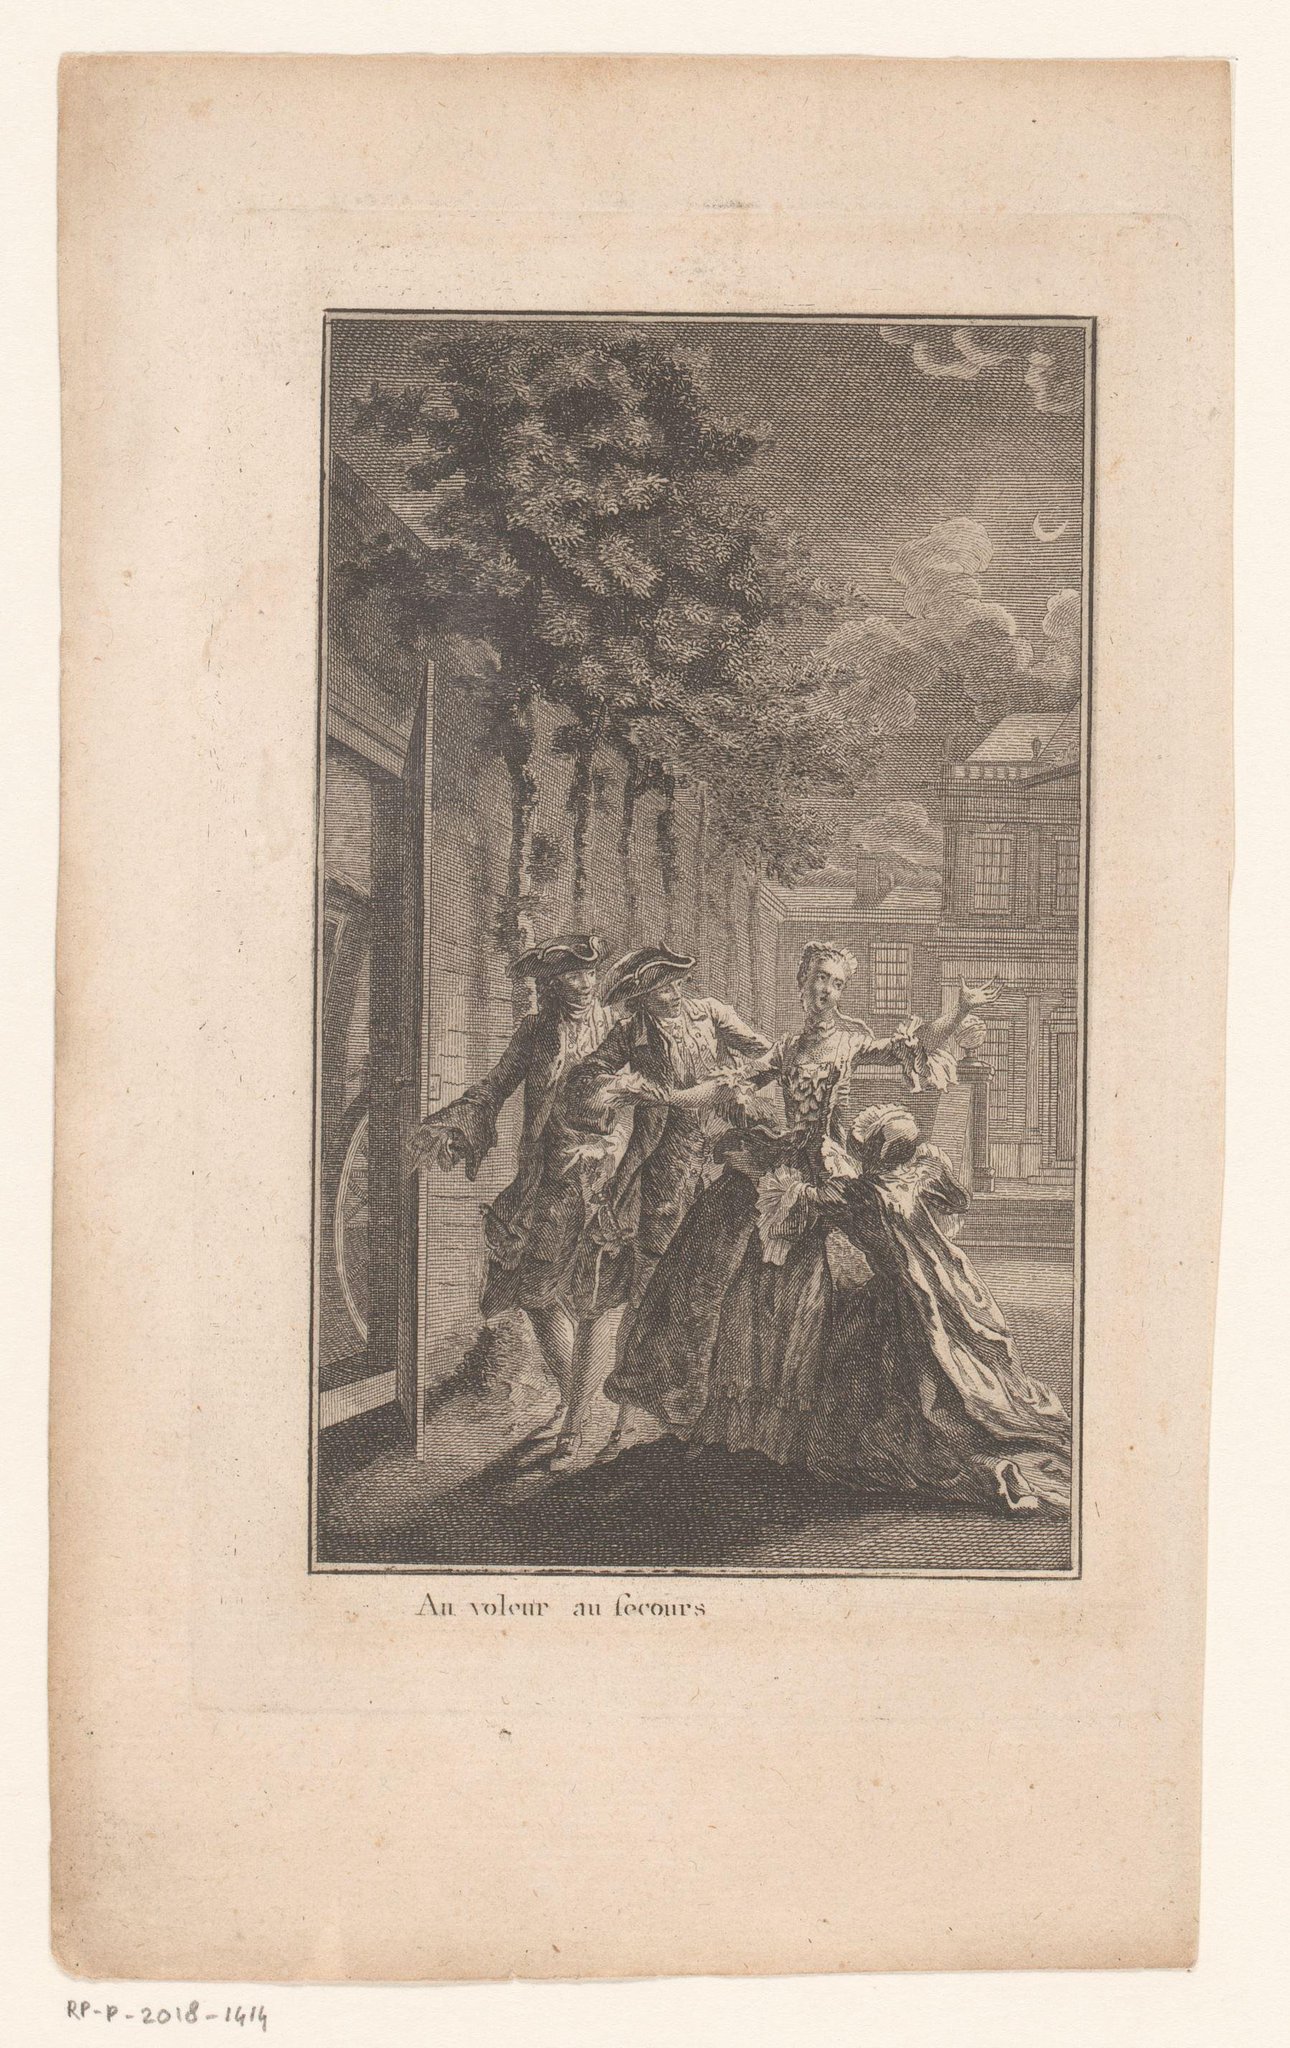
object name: book illustration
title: Scène uit La Veuve met vier figuren op een binnenplaats bij nacht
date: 1763-1764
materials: paper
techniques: etching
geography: geneva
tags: theatre, theatrical performance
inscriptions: collector's mark: Lugt 2228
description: Prent uit: Corneille, Pierre. Théâtre (...). Genève: Cramer, 1764. Dit betreft een illustratie op p. 119 uit deel 11, getiteld 'La Veuve'.